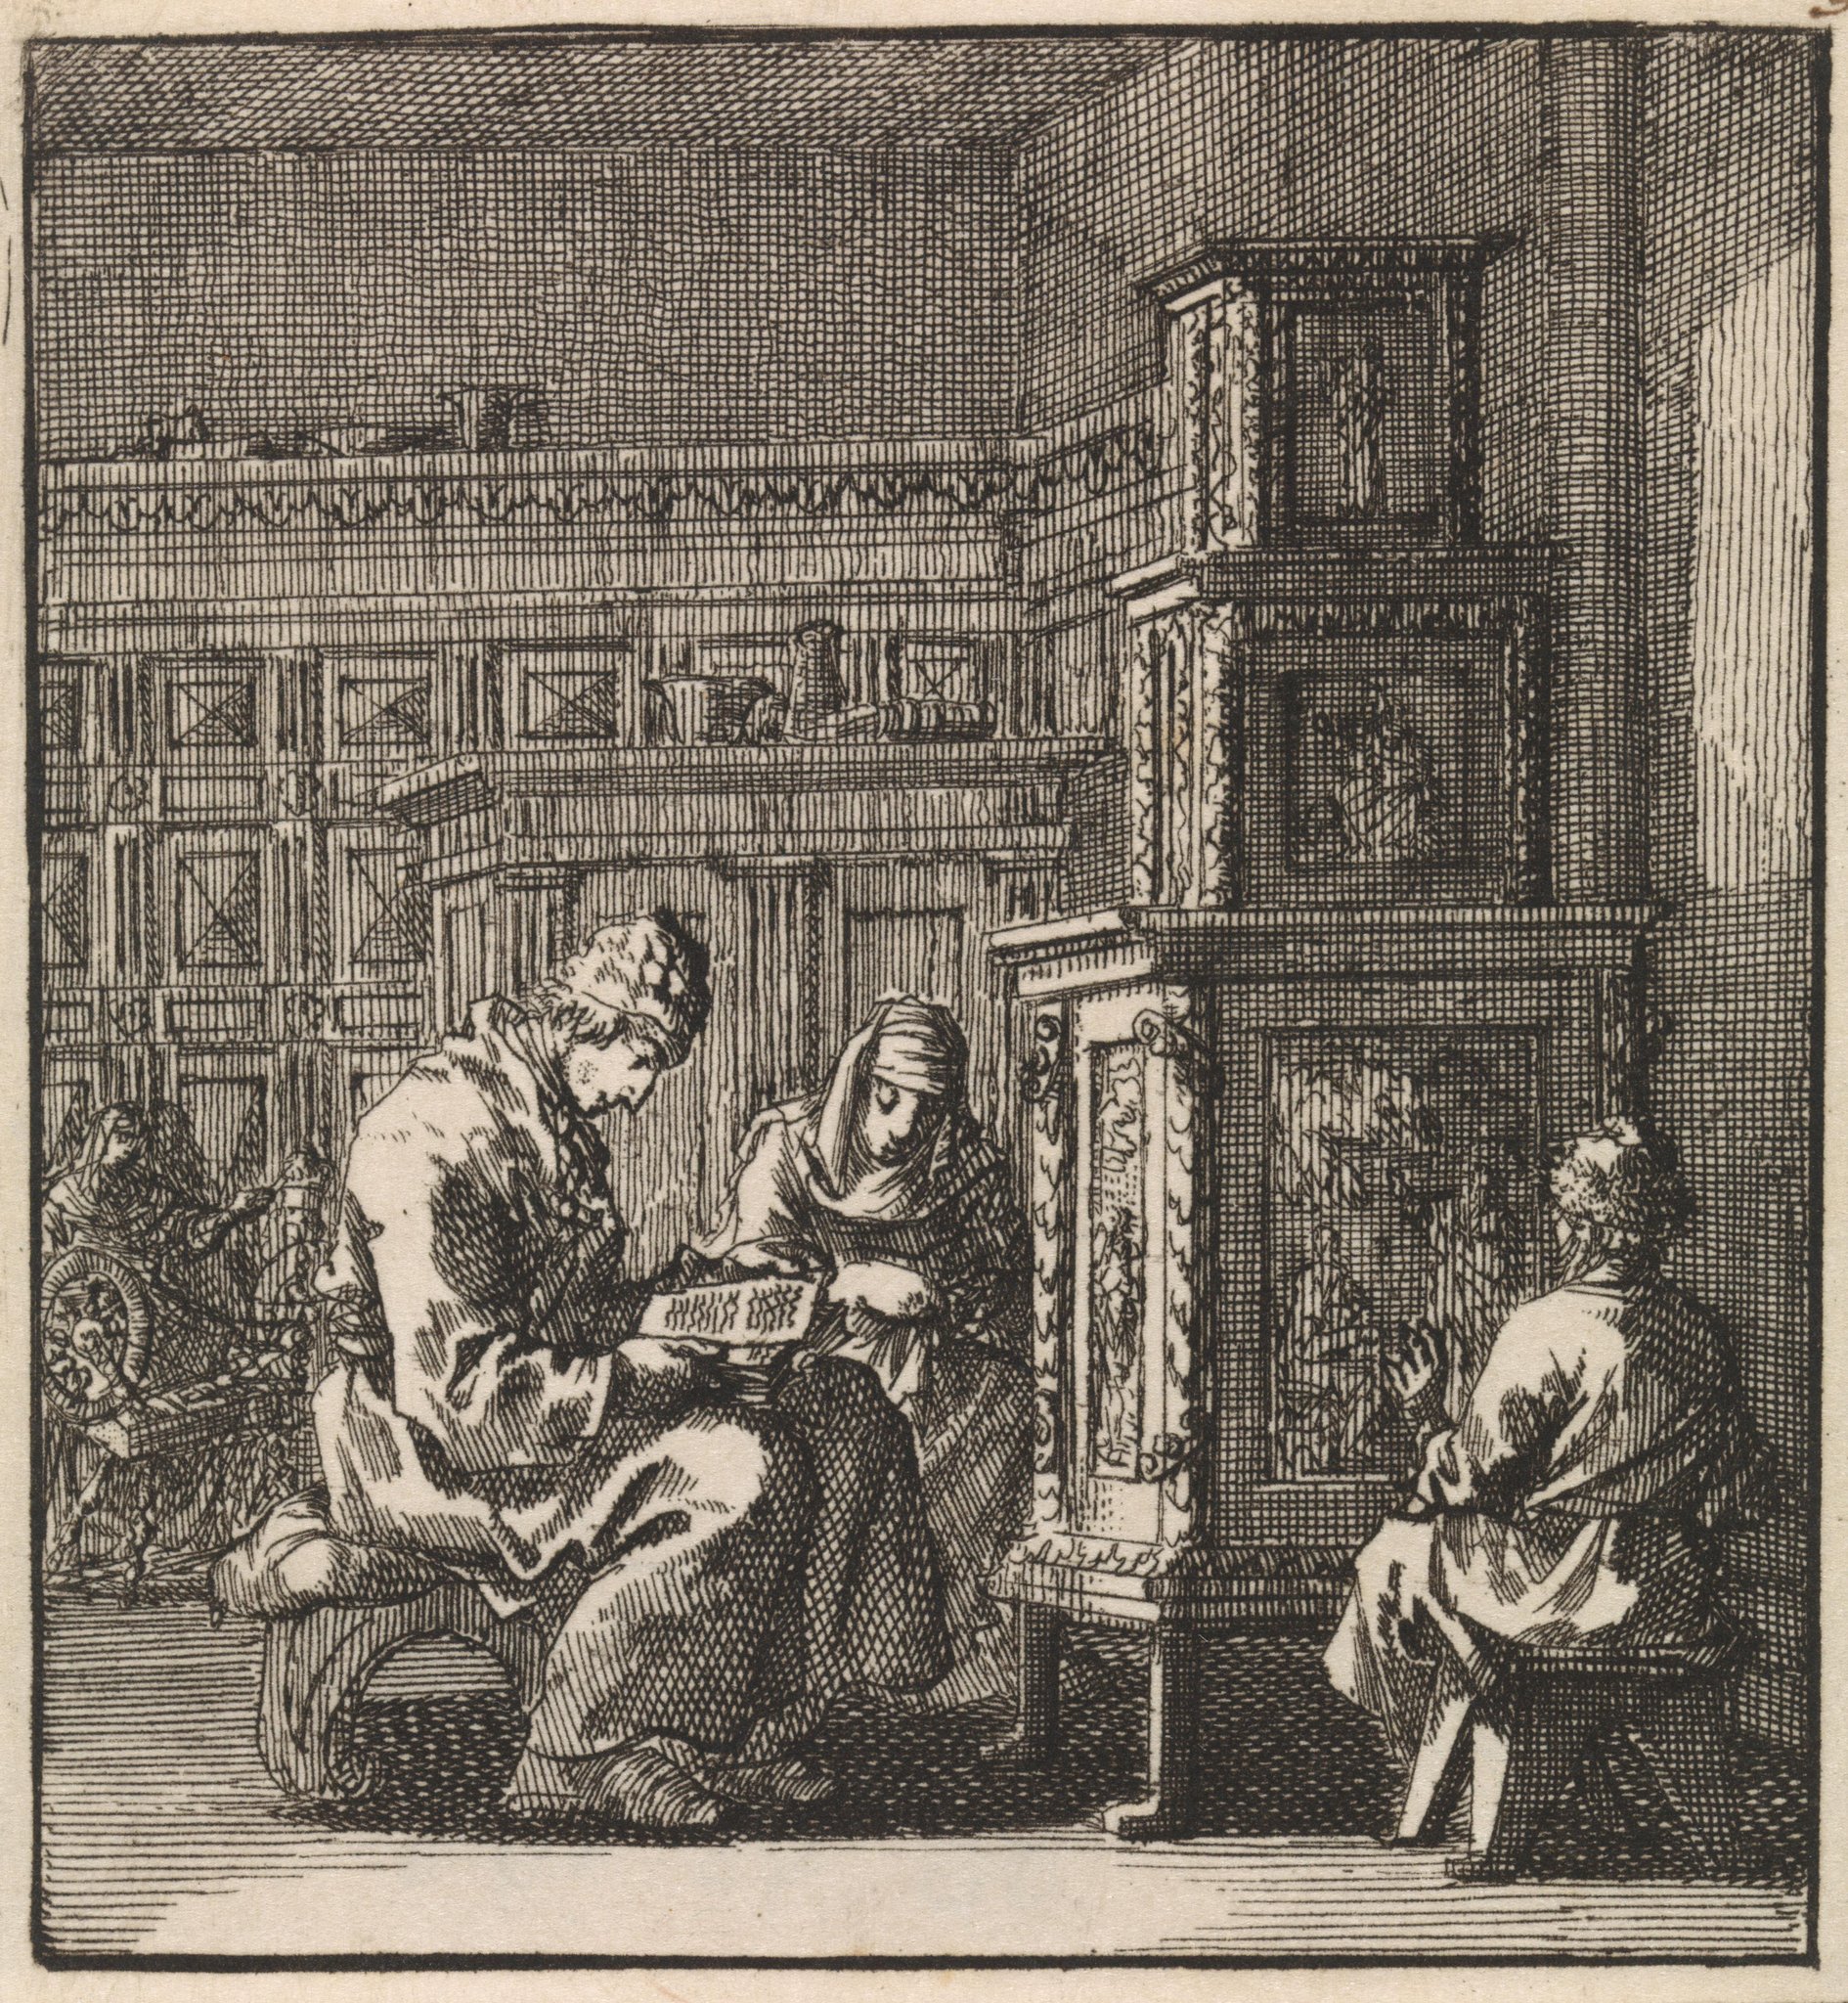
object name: print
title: De Kachel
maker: jan luyken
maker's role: draughtsman, print maker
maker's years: 1649-1712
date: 1711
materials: paper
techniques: etching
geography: amsterdam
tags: reading, heating stove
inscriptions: collector's mark: Lugt 2228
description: Proefdruk van illustratie voor: Luyken, Jan. Het leerzaam huisraad, vertoond in vyftig konstige figuuren, met godlyke spreuken en stichtelyke verzen: Pieter Arentsz. II (wed.) en Cornelis van der Sys, 1711, p. 30.